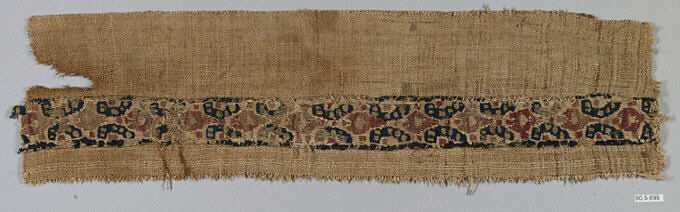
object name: textile fragment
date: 401-600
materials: linen, wool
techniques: weave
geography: egypt